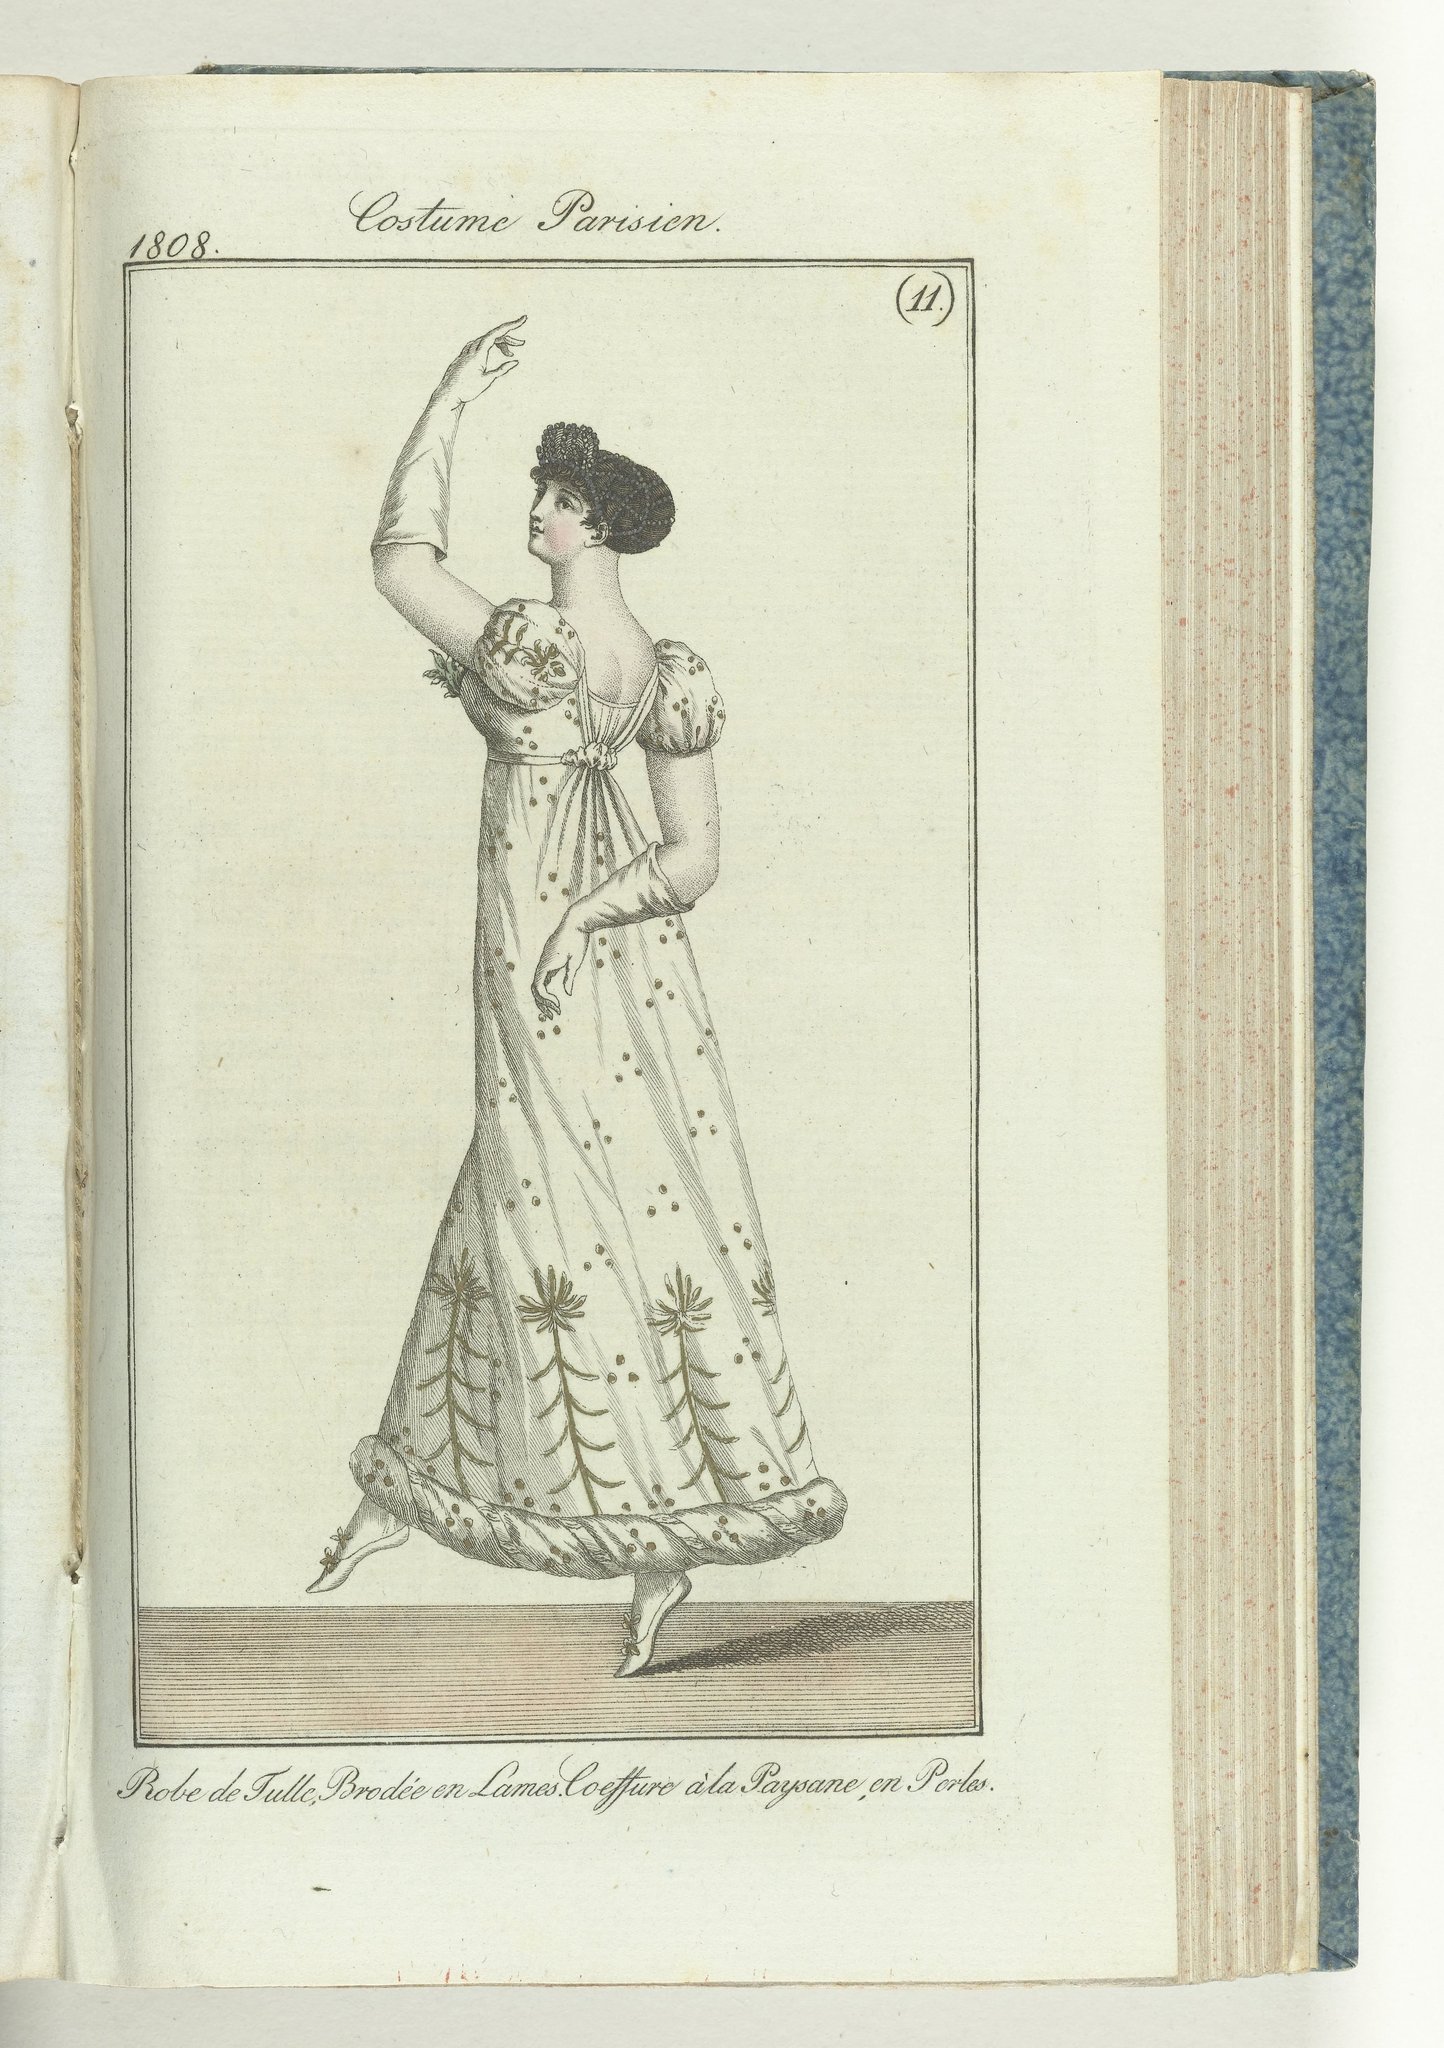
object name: magazine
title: Journal des Dames et des Modes, editie Frankfurt 14 mars 1808, Costume Parisien (11): Robe de Tulle...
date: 1808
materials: paper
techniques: engraving, hand coloring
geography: frankfurt am main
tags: gloves, mittens (long gloves) (+ women's clothes), woman dancing alone, embroidery (ornamentation) (+ women's clothes), styles of hairdress - aa - ~ women, fashion plates, shoes, sandals (+ women's clothes), dress, gown (+ women's clothes)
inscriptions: caption: ‘Robe de Tulle, Brodée en Lames. Coeffure à la Paysanne en Perles’, title: ‘Costume Parisien.’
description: Volgens de begeleidende tekst (p. 288): Coiffure à la Paysanne, versierd met parels. Japon van tule, geborduurd met gouddraad. Witte handschoenen. Witte schoenen. De prent maakt deel uit van het modetijdschrift Journal des Dames et des Modes, uitgegeven in Frankfurt als kopie van de Franse editie van Pierre de la Mésangère, (1798-1848).